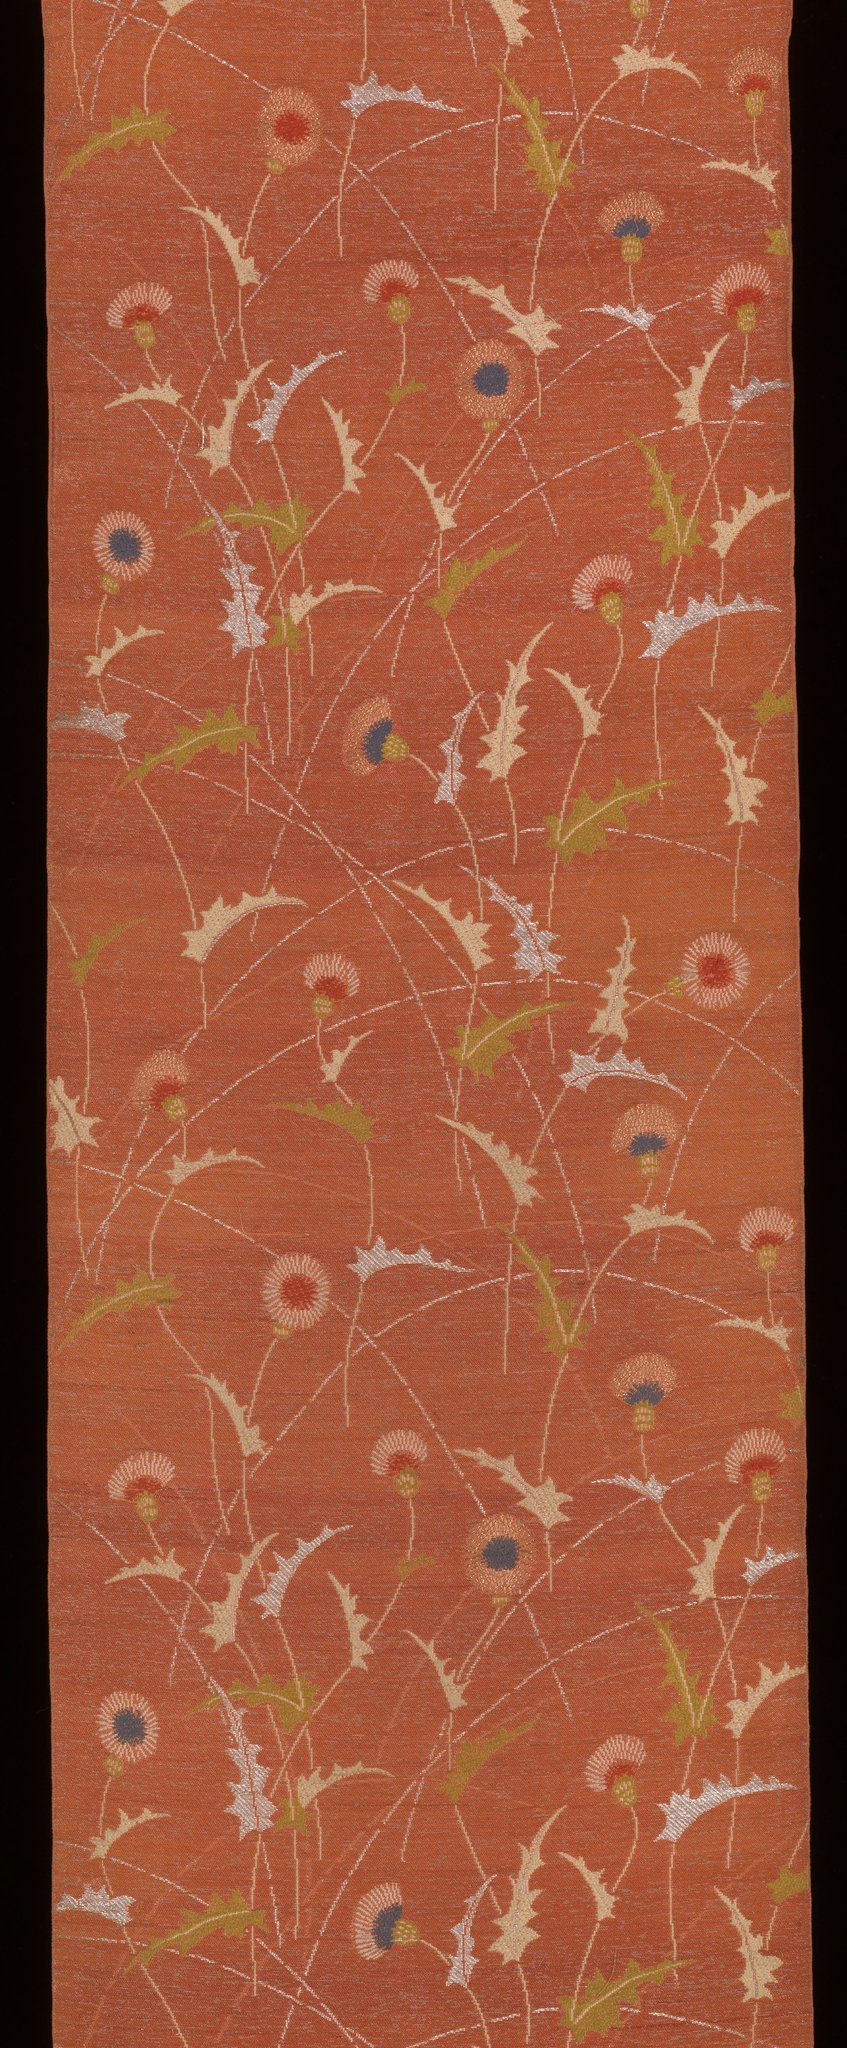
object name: obi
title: Obi with Thistle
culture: japanese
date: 1851-1900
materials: metal thread, silk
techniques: brocade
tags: flowers